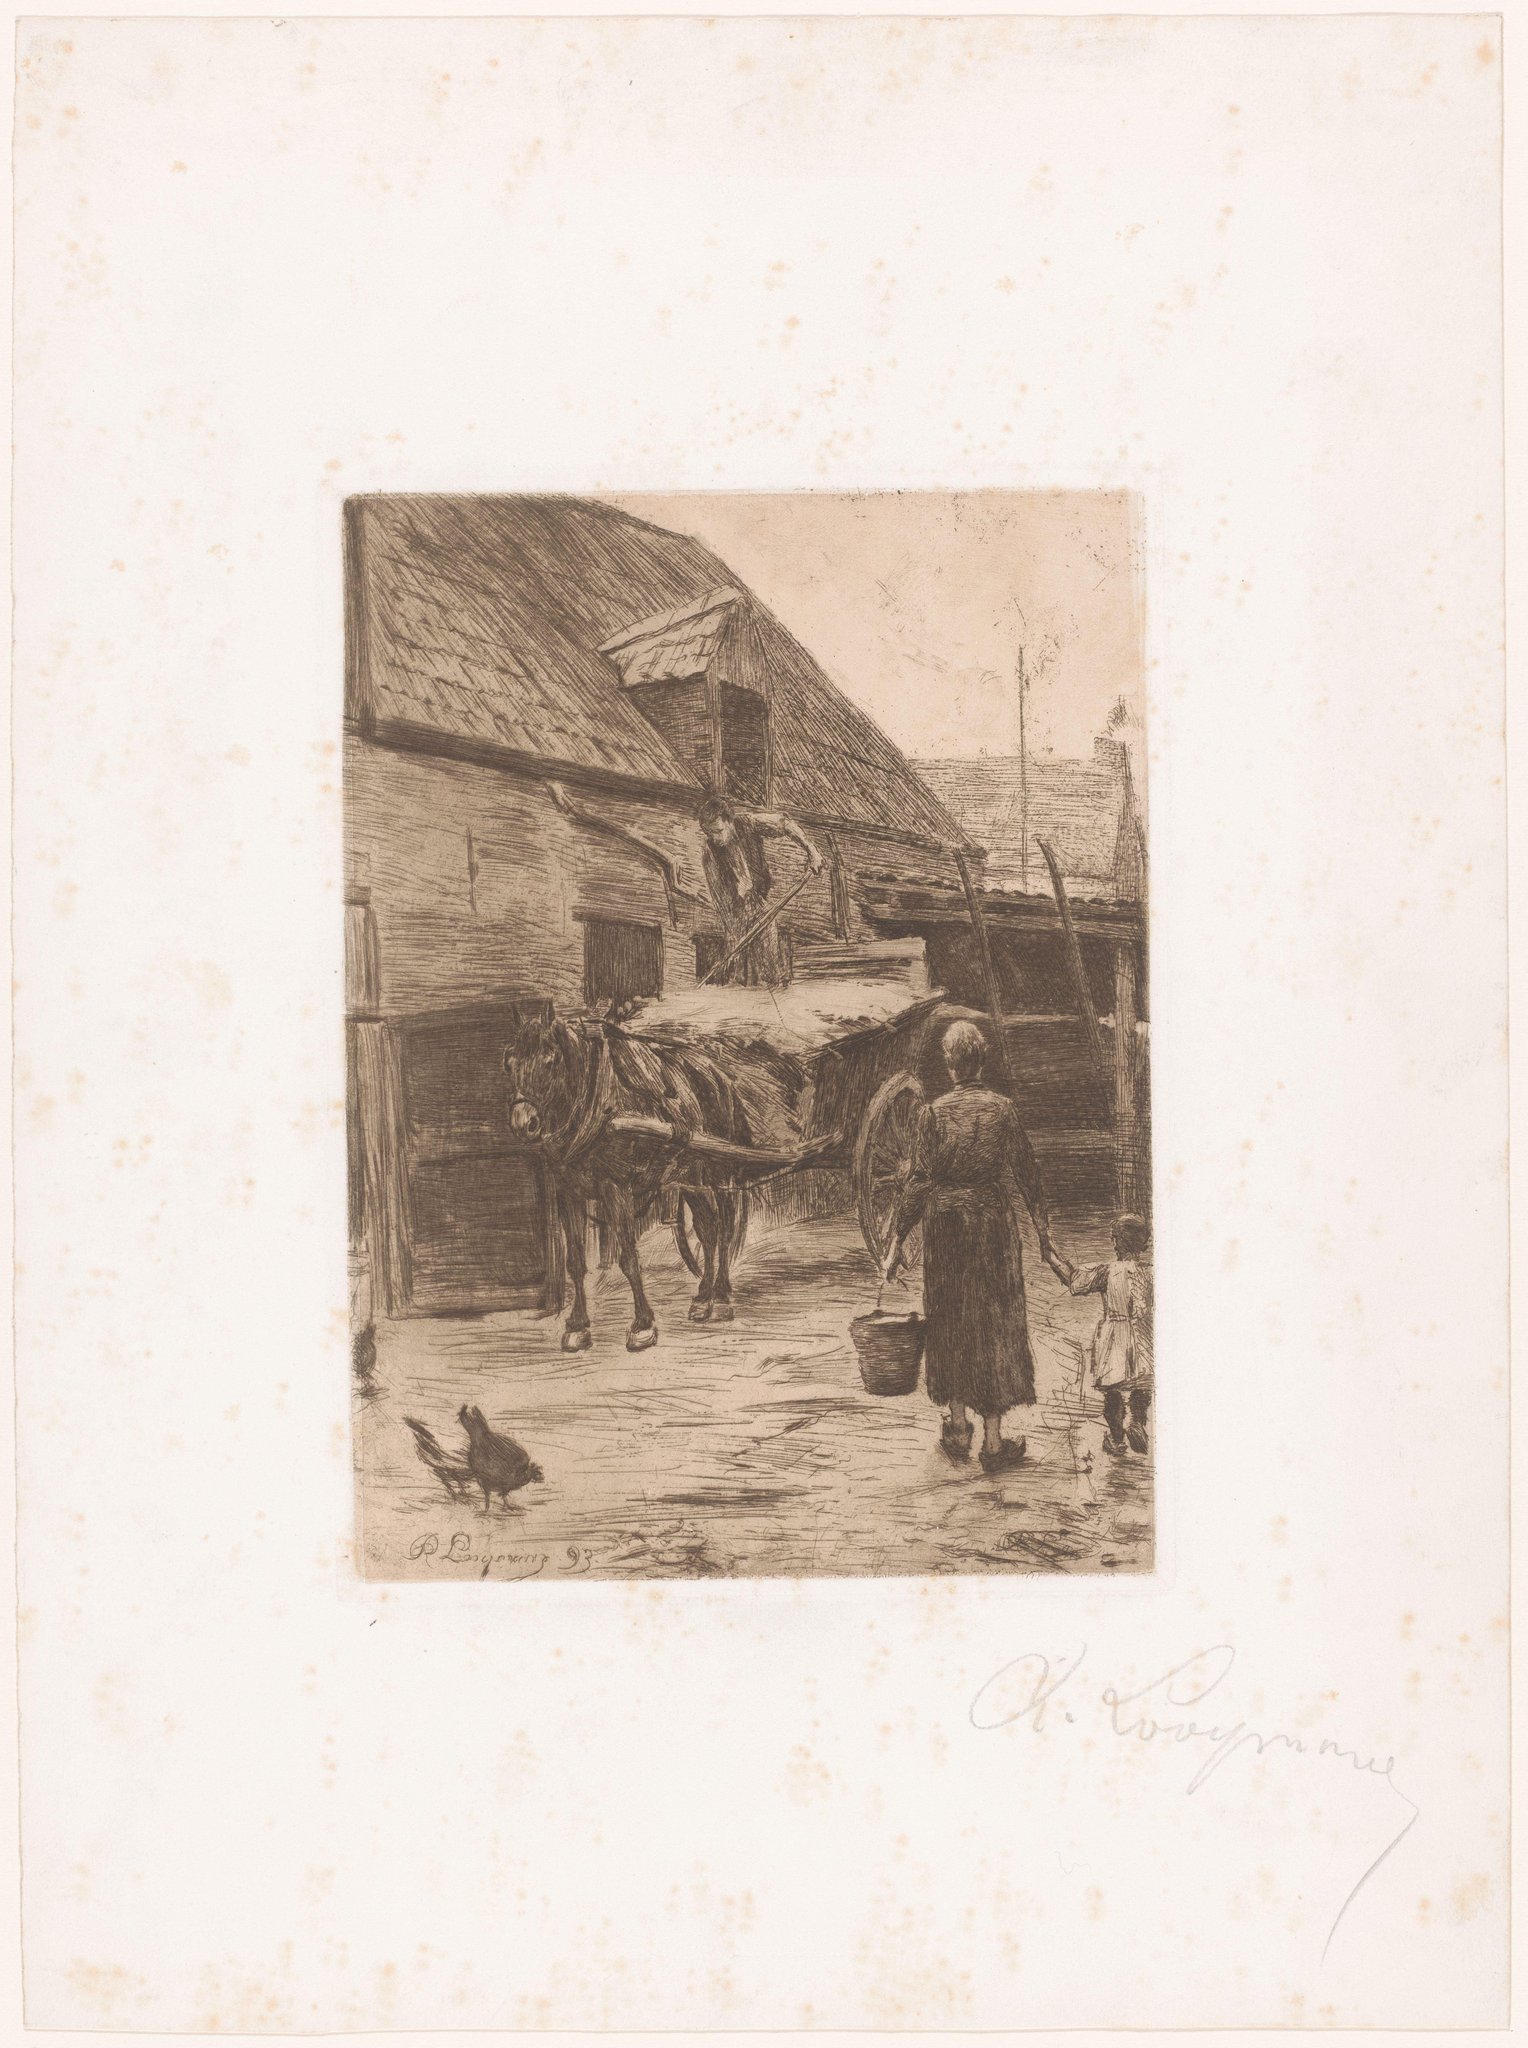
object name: print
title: Boer laadt hooi van een wagen terwijl boerin en zoon aan komen lopen met een emmer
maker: romain looymans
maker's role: print maker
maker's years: 1864-1914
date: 1893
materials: paper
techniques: drypoint, etching, intaglio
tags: farmers, courtyard, farm (building)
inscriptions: collector's mark: Lugt 2228